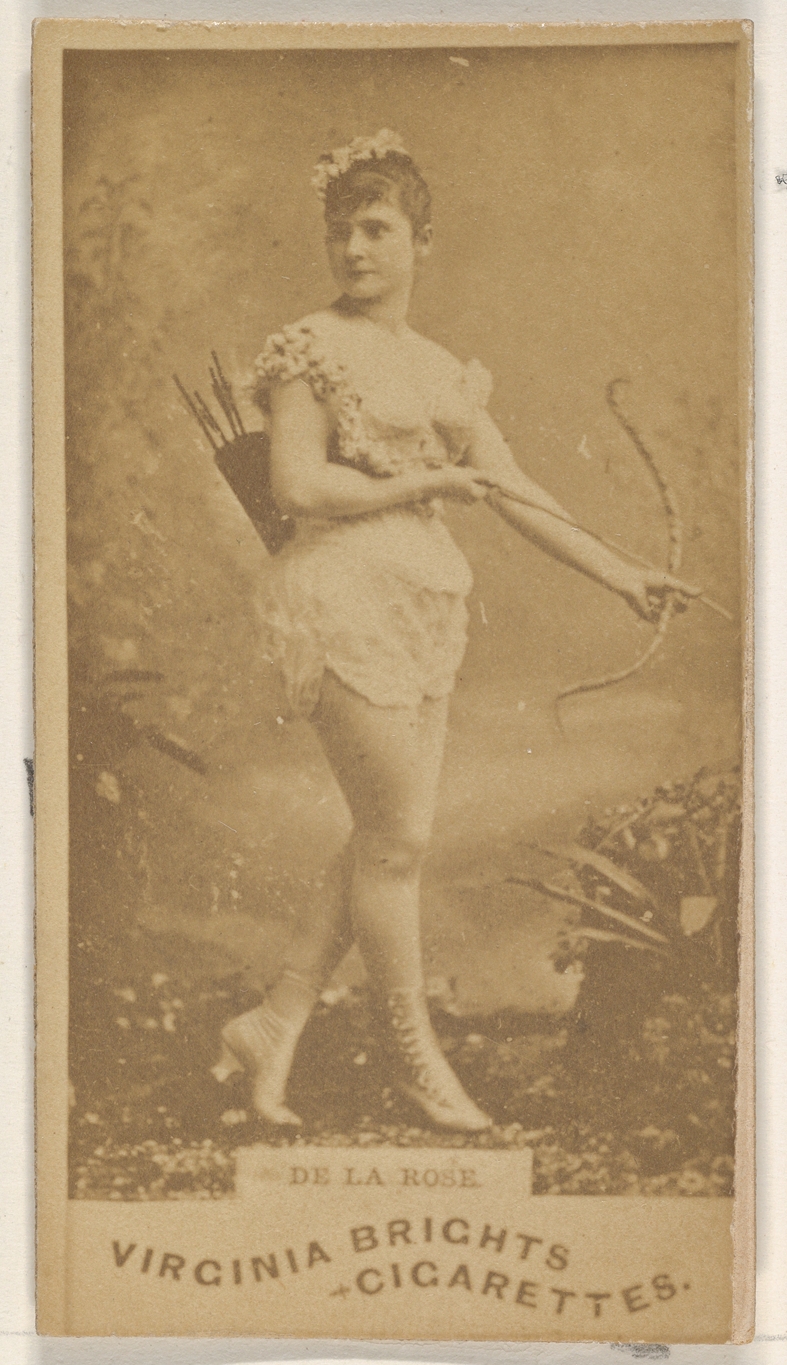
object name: photograph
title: De La Rose, from the Actors and Actresses series (N45, Type 1) for Virginia Brights Cigarettes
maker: allen & ginter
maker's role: publisher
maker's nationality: american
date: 1888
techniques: albumen silver print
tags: bow and arrow,portraits,women,actresses